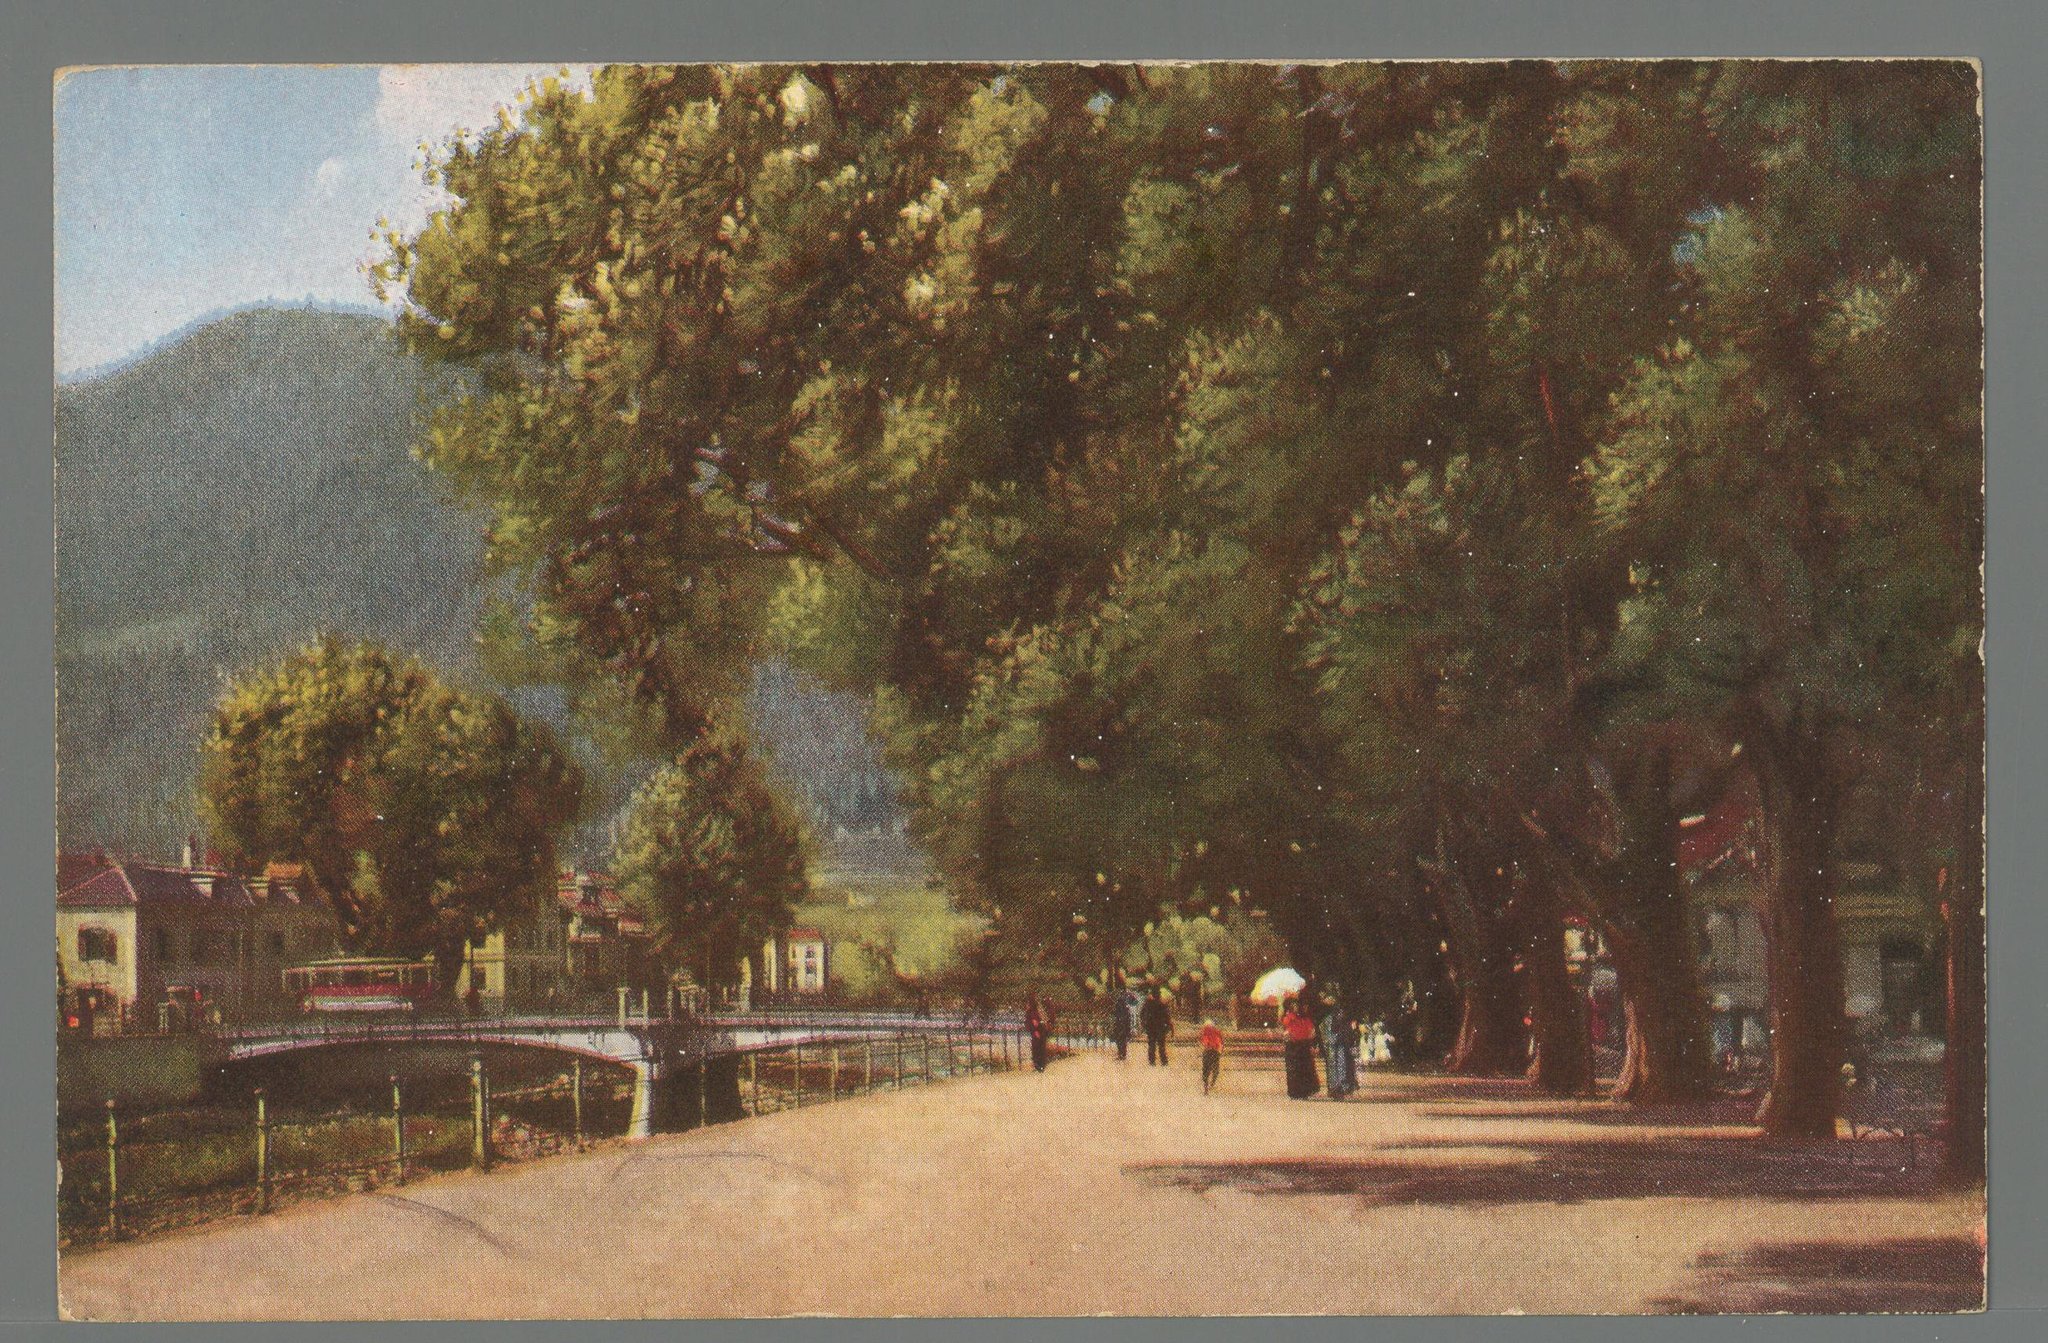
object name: ansichtkaart, prentbriefkaart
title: Kurort Meran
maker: Anonymous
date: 1905-1929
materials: cardboard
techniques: four-color autotype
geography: merano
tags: trees, avenue, boulevard, promenade, esplanade, mountains